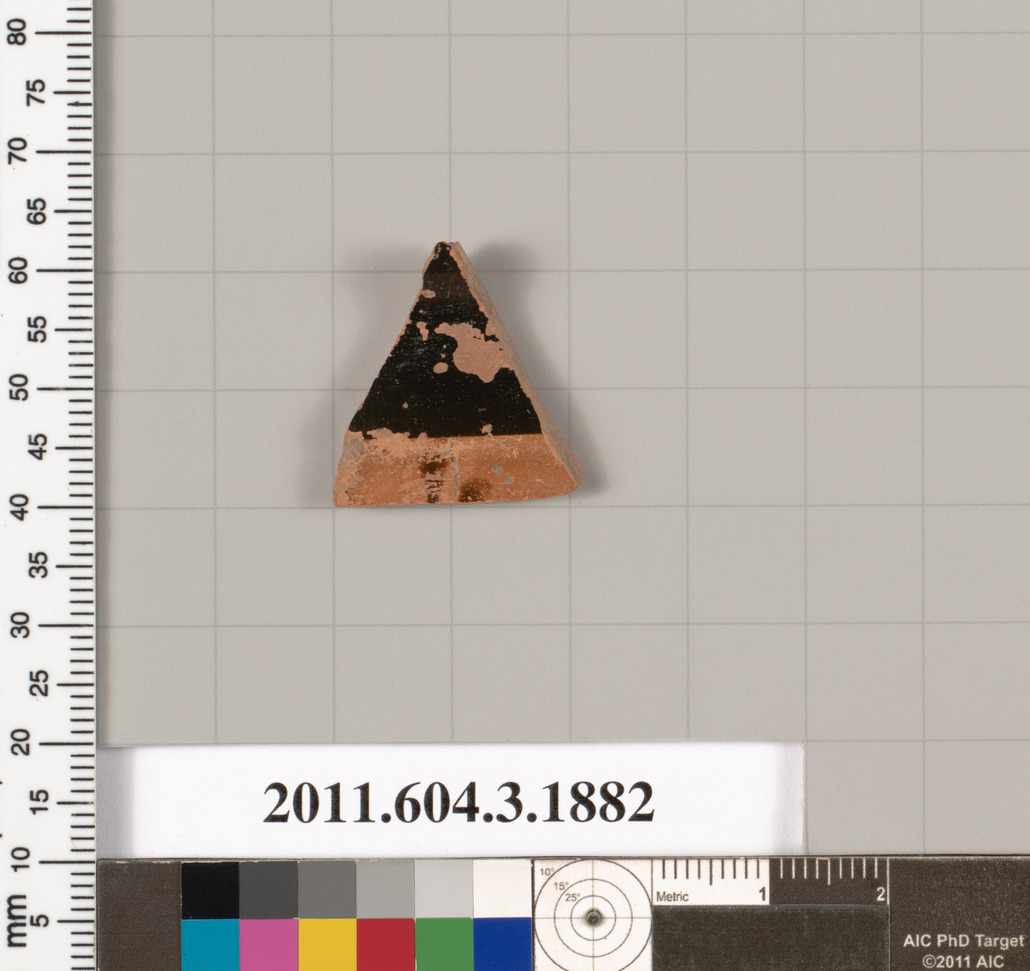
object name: mastoid fragment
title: Terracotta fragment of a mastoid (drinking cup with narrow base) ?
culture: greek, attic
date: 534-468 BCE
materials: terracotta